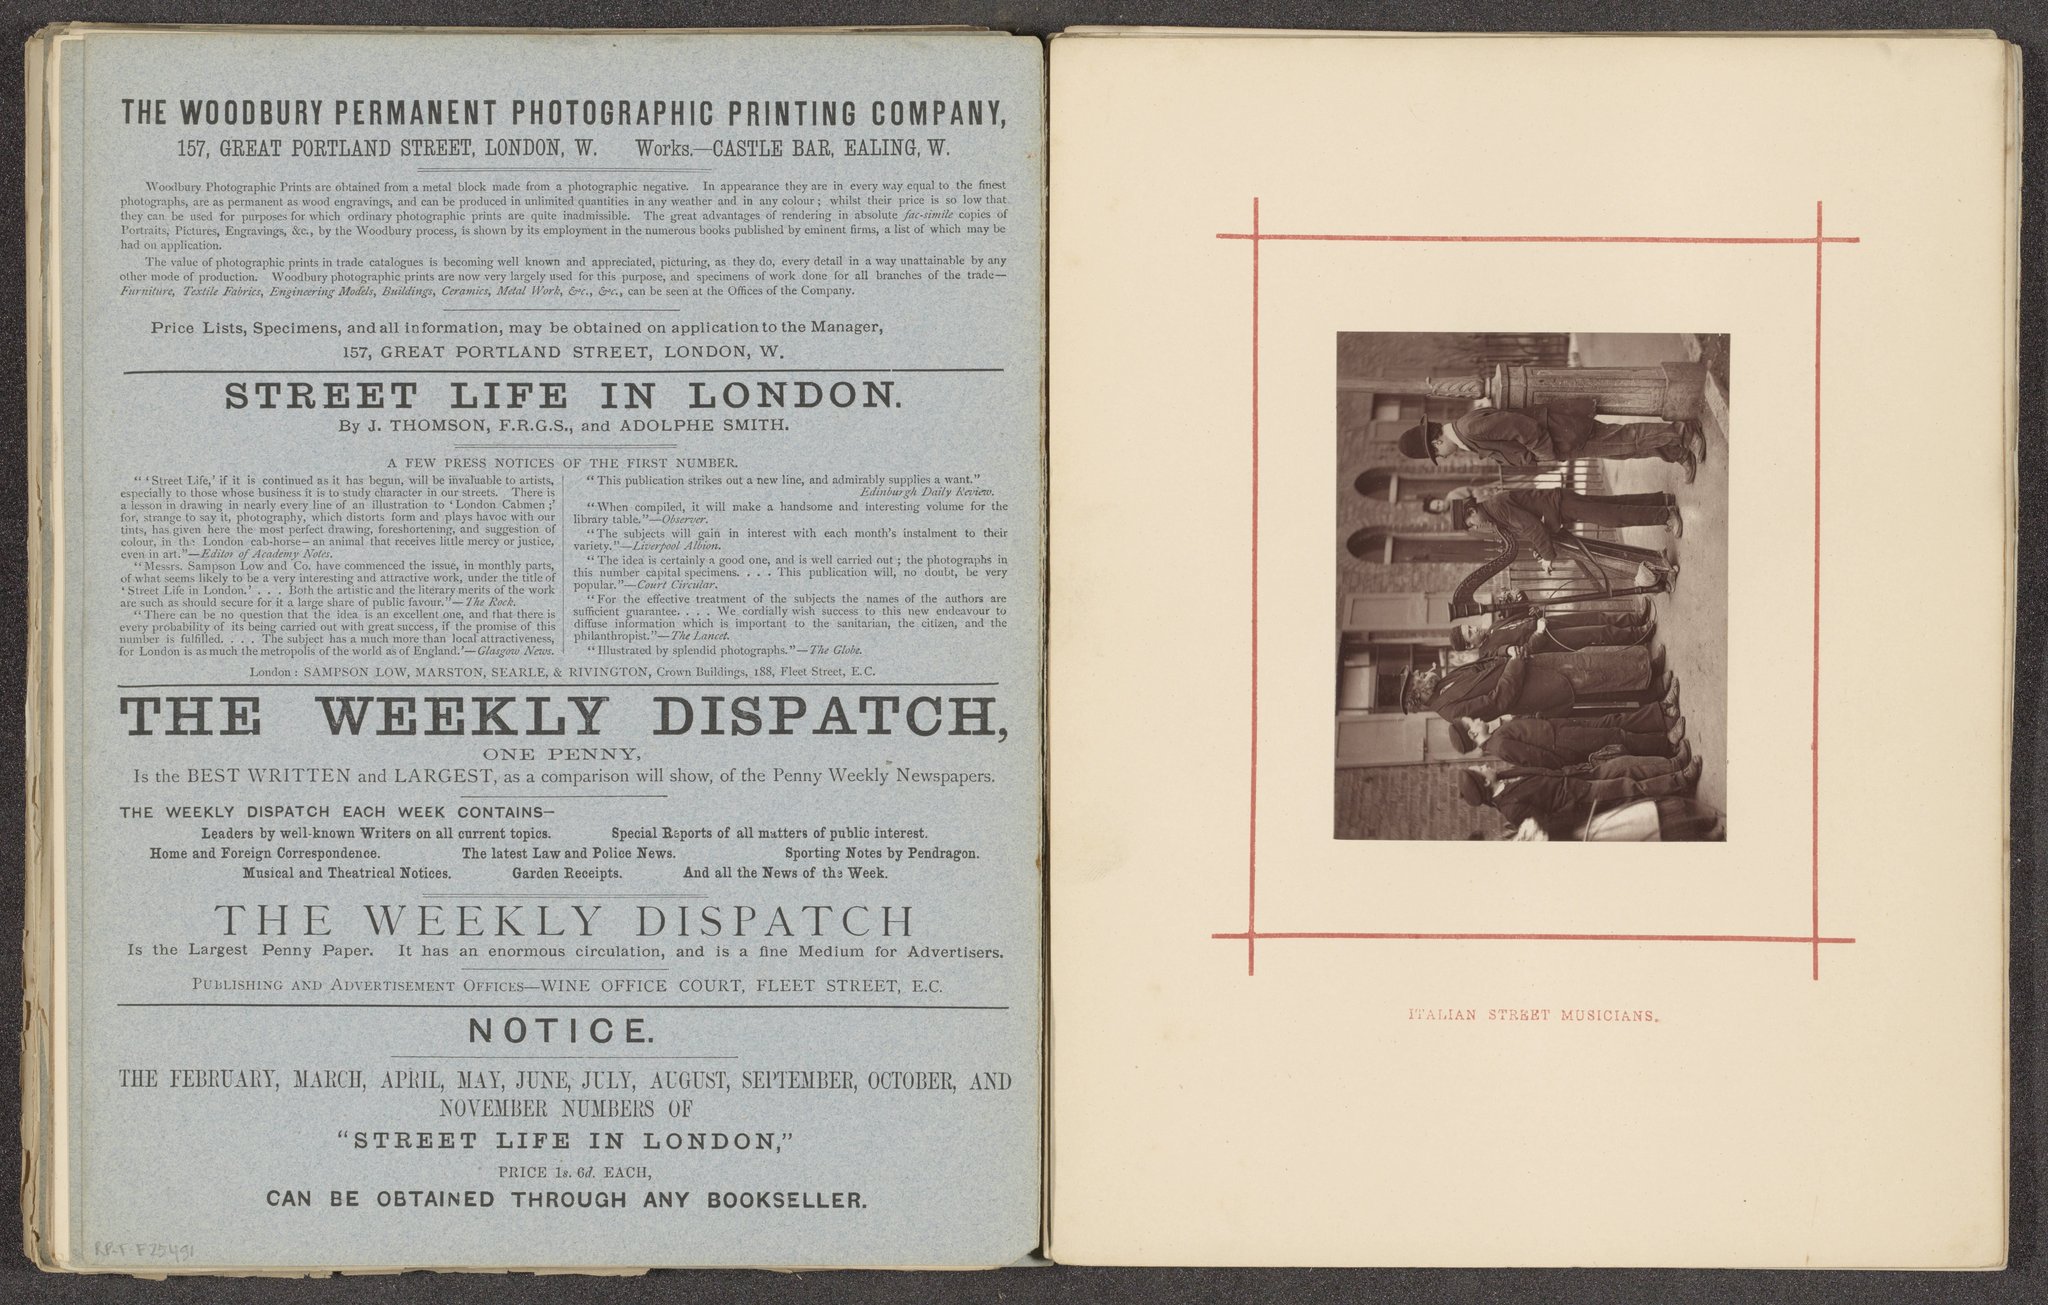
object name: photomechanical print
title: Italian street musicians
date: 1876-1877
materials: paper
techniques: woodburytype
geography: london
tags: musician - cc - out of doors, london